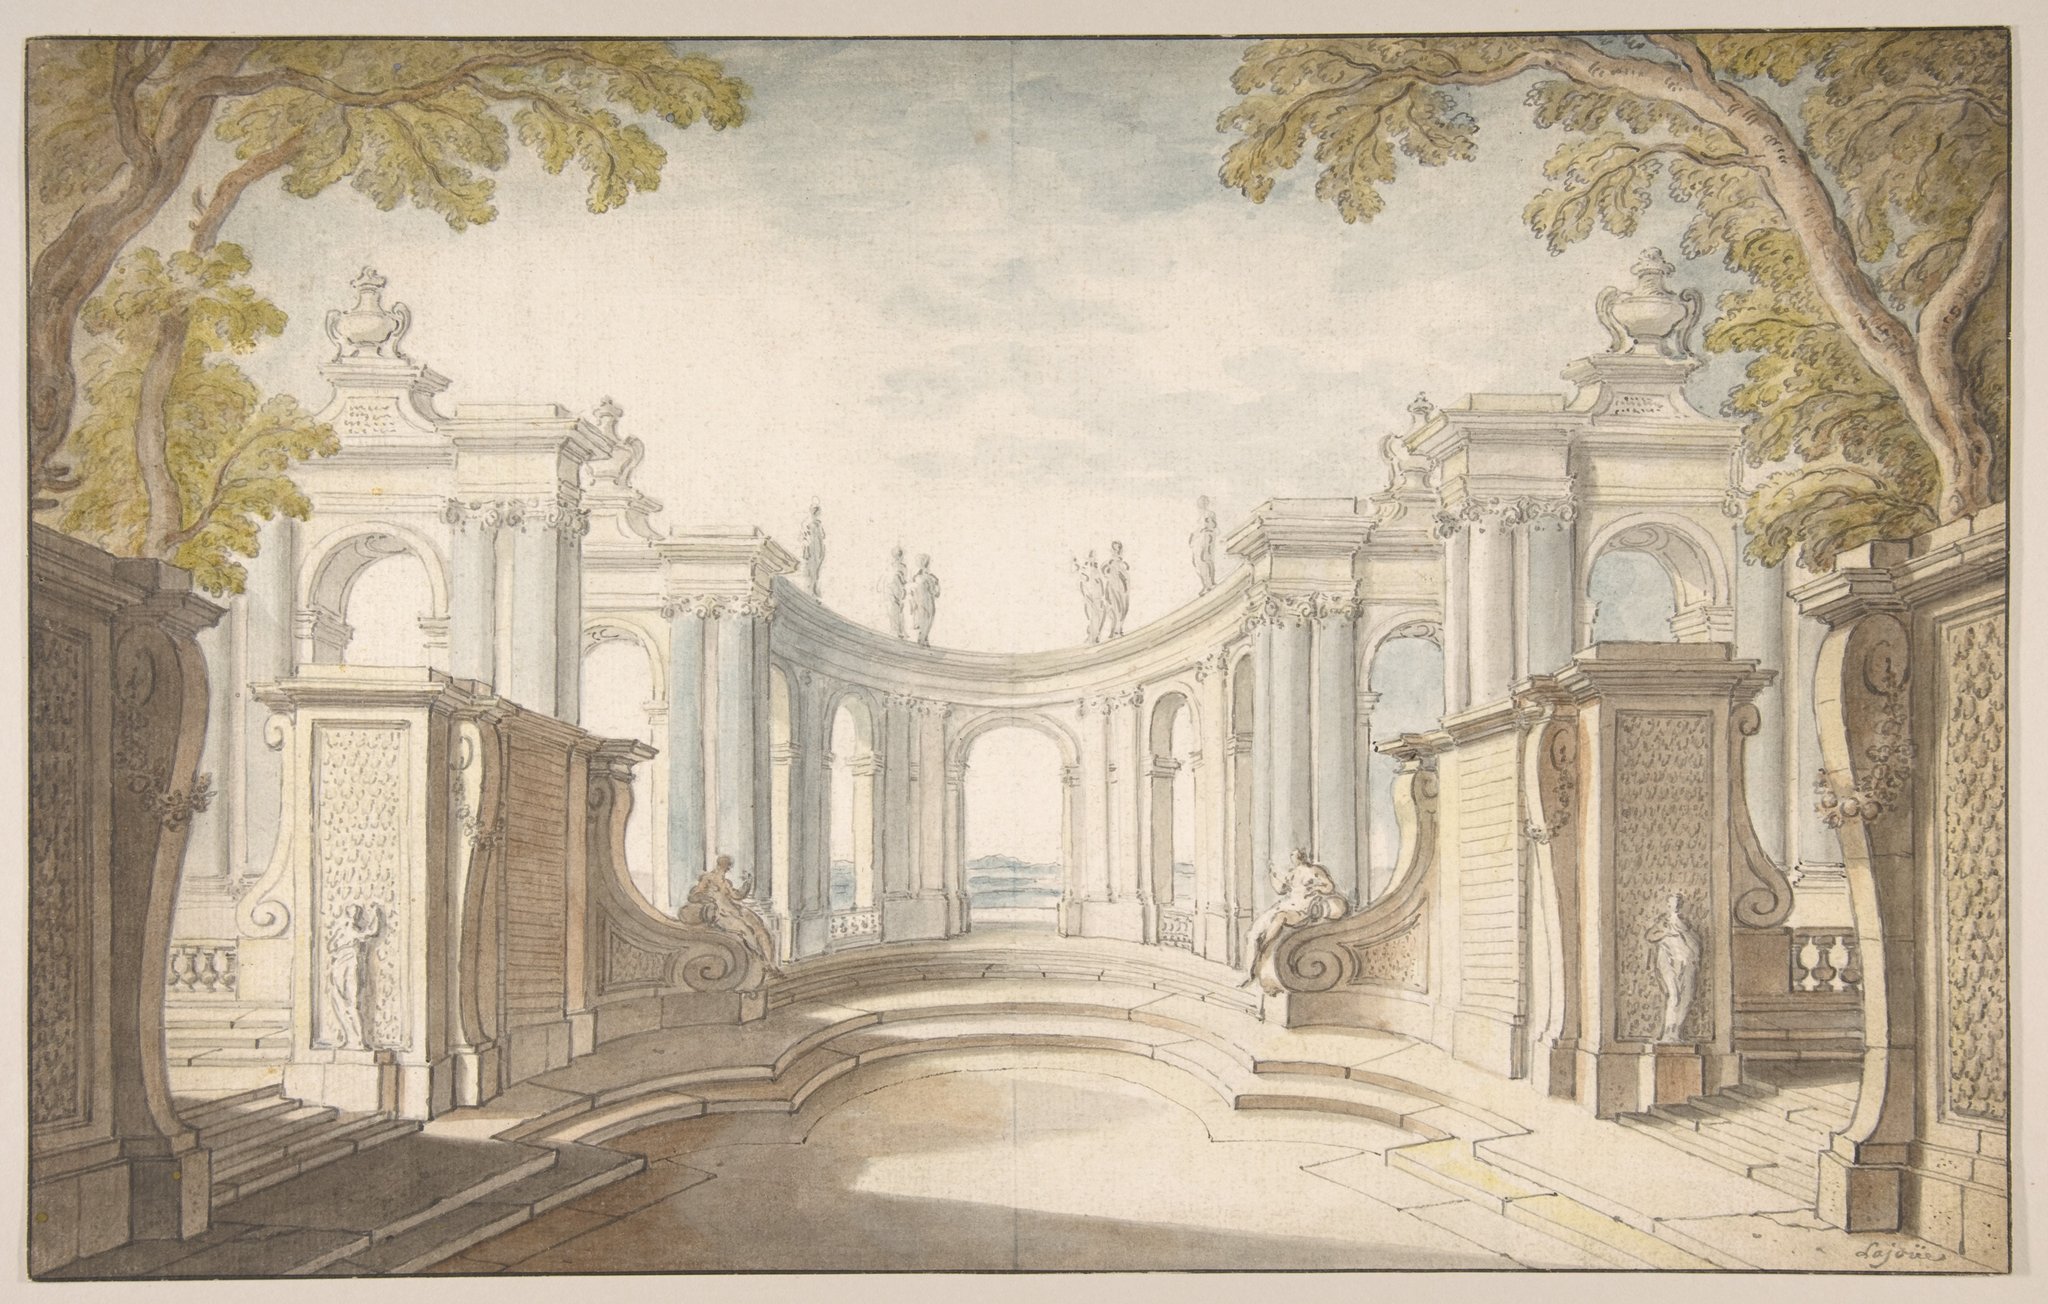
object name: drawing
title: Study for a Stage Set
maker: jacques de lajoüe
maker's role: artist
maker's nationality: french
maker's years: 1686-1761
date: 1701-1800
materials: chalk, graphite, ink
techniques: brush, pen, wash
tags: stage design